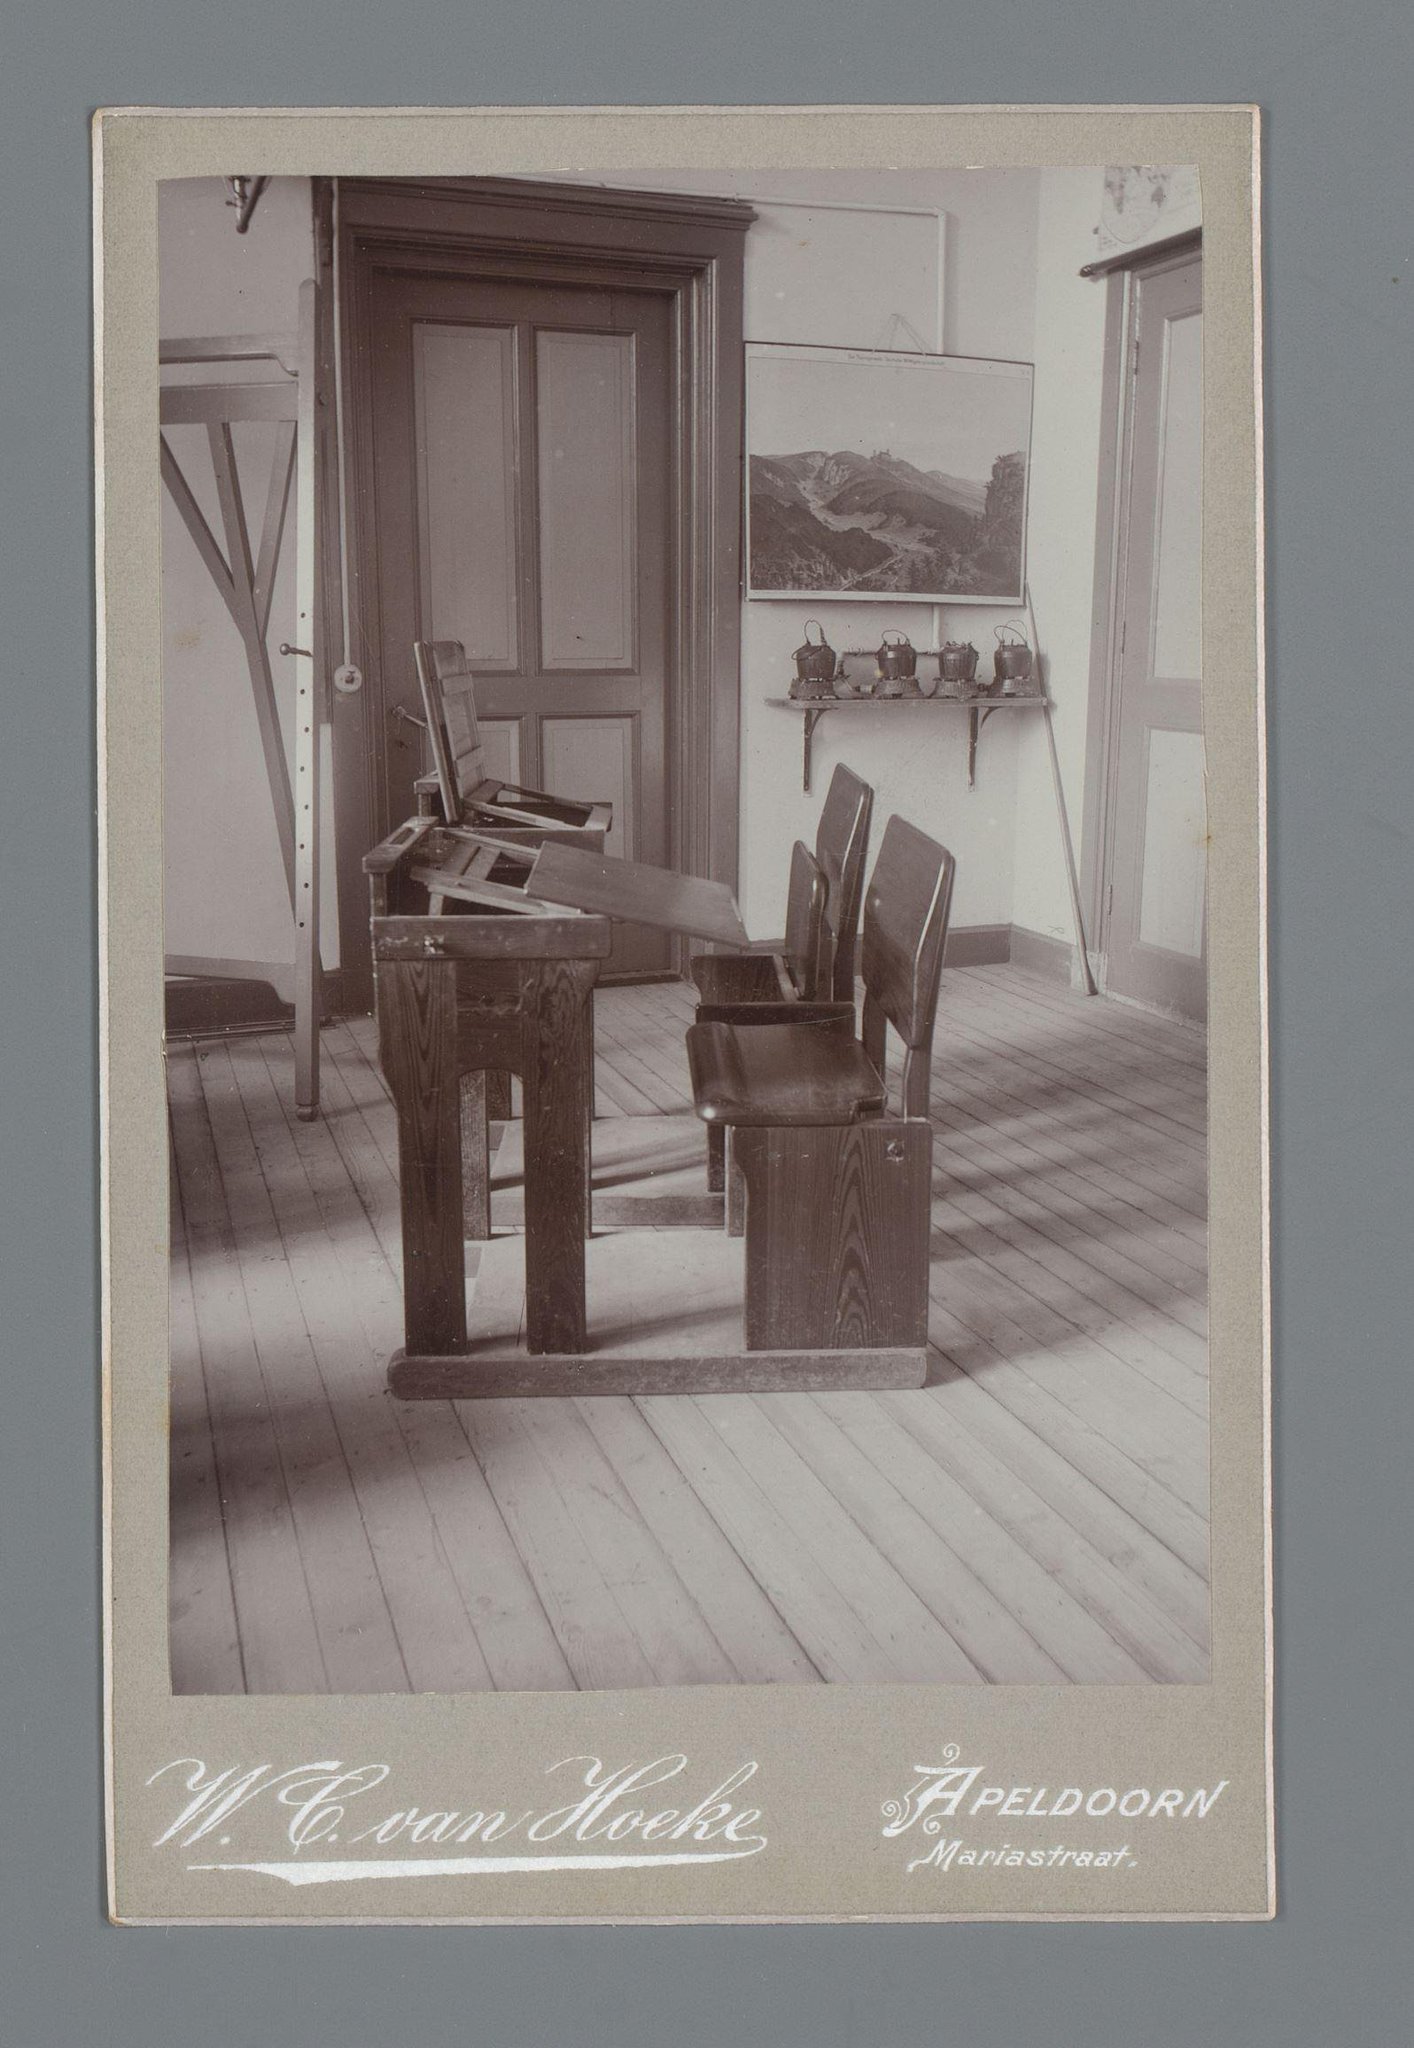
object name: cabinet photograph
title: Klaslokaal met schoolbanken, geografische wandkaart en ketels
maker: willem cornelis van hoeke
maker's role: fotograaf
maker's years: 1853-1929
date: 1892-1917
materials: cardboard, photographic support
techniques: collodion silver print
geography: apeldoorn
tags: writing-table, writing-desk, elementary school; class, form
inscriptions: address: ‘APELDOORN/ Mariastraat.’